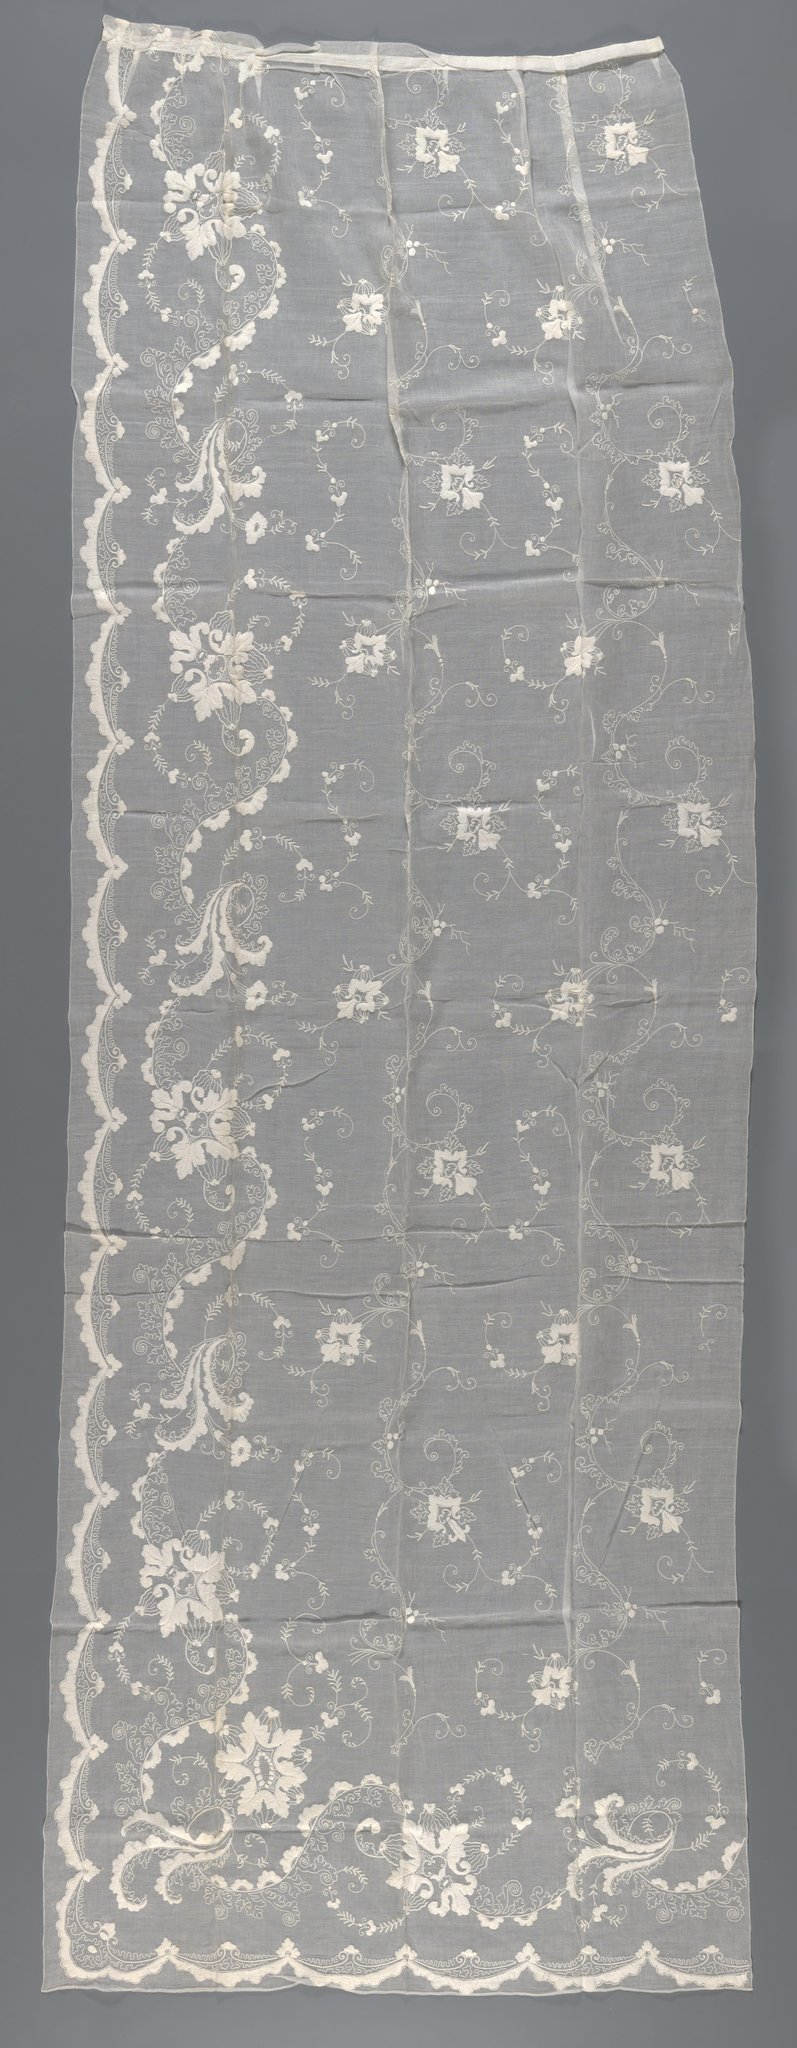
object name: bed curtain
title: Bedgordijn van glasbatist, versierd met tule doorstopborduursel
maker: Anonymous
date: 1800-1874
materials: textile, copper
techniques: stopwork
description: Bedgordijn van glasbatist, versierd met tule doorstopborduursel (wit op wit) in de vorm van bloemornament en voluten. Aangenaaid linnen band met vier koperen ringen.